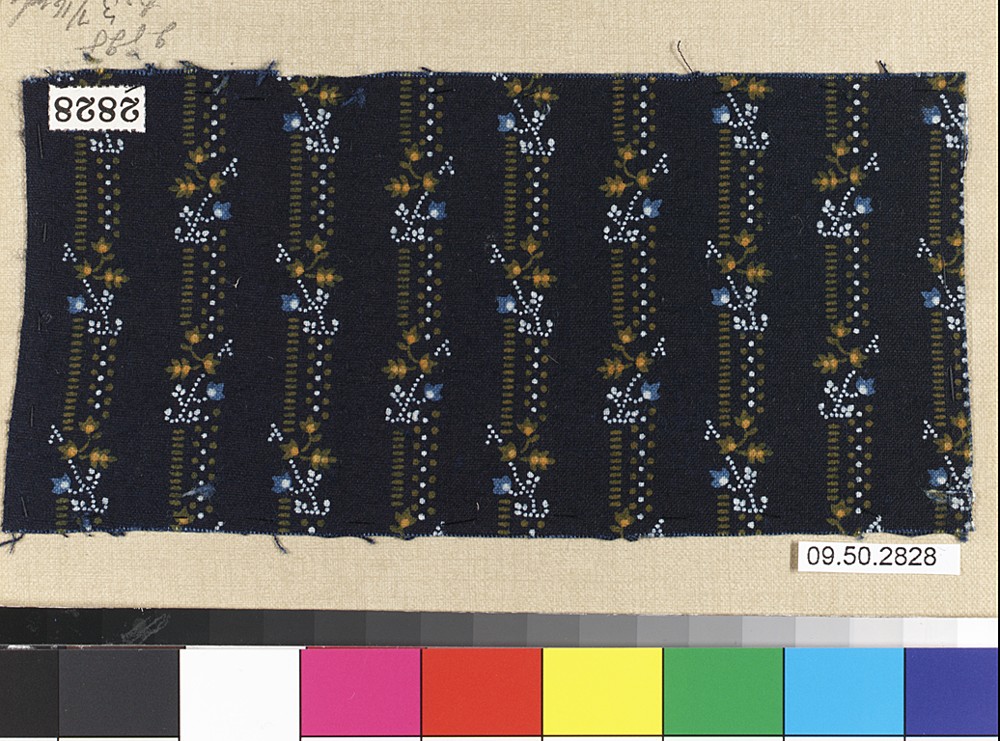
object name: piece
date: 1801-1900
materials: cotton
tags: plants